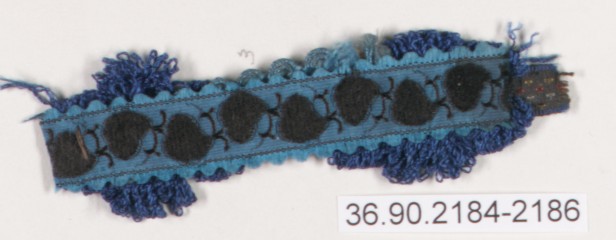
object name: piece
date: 1801-1900